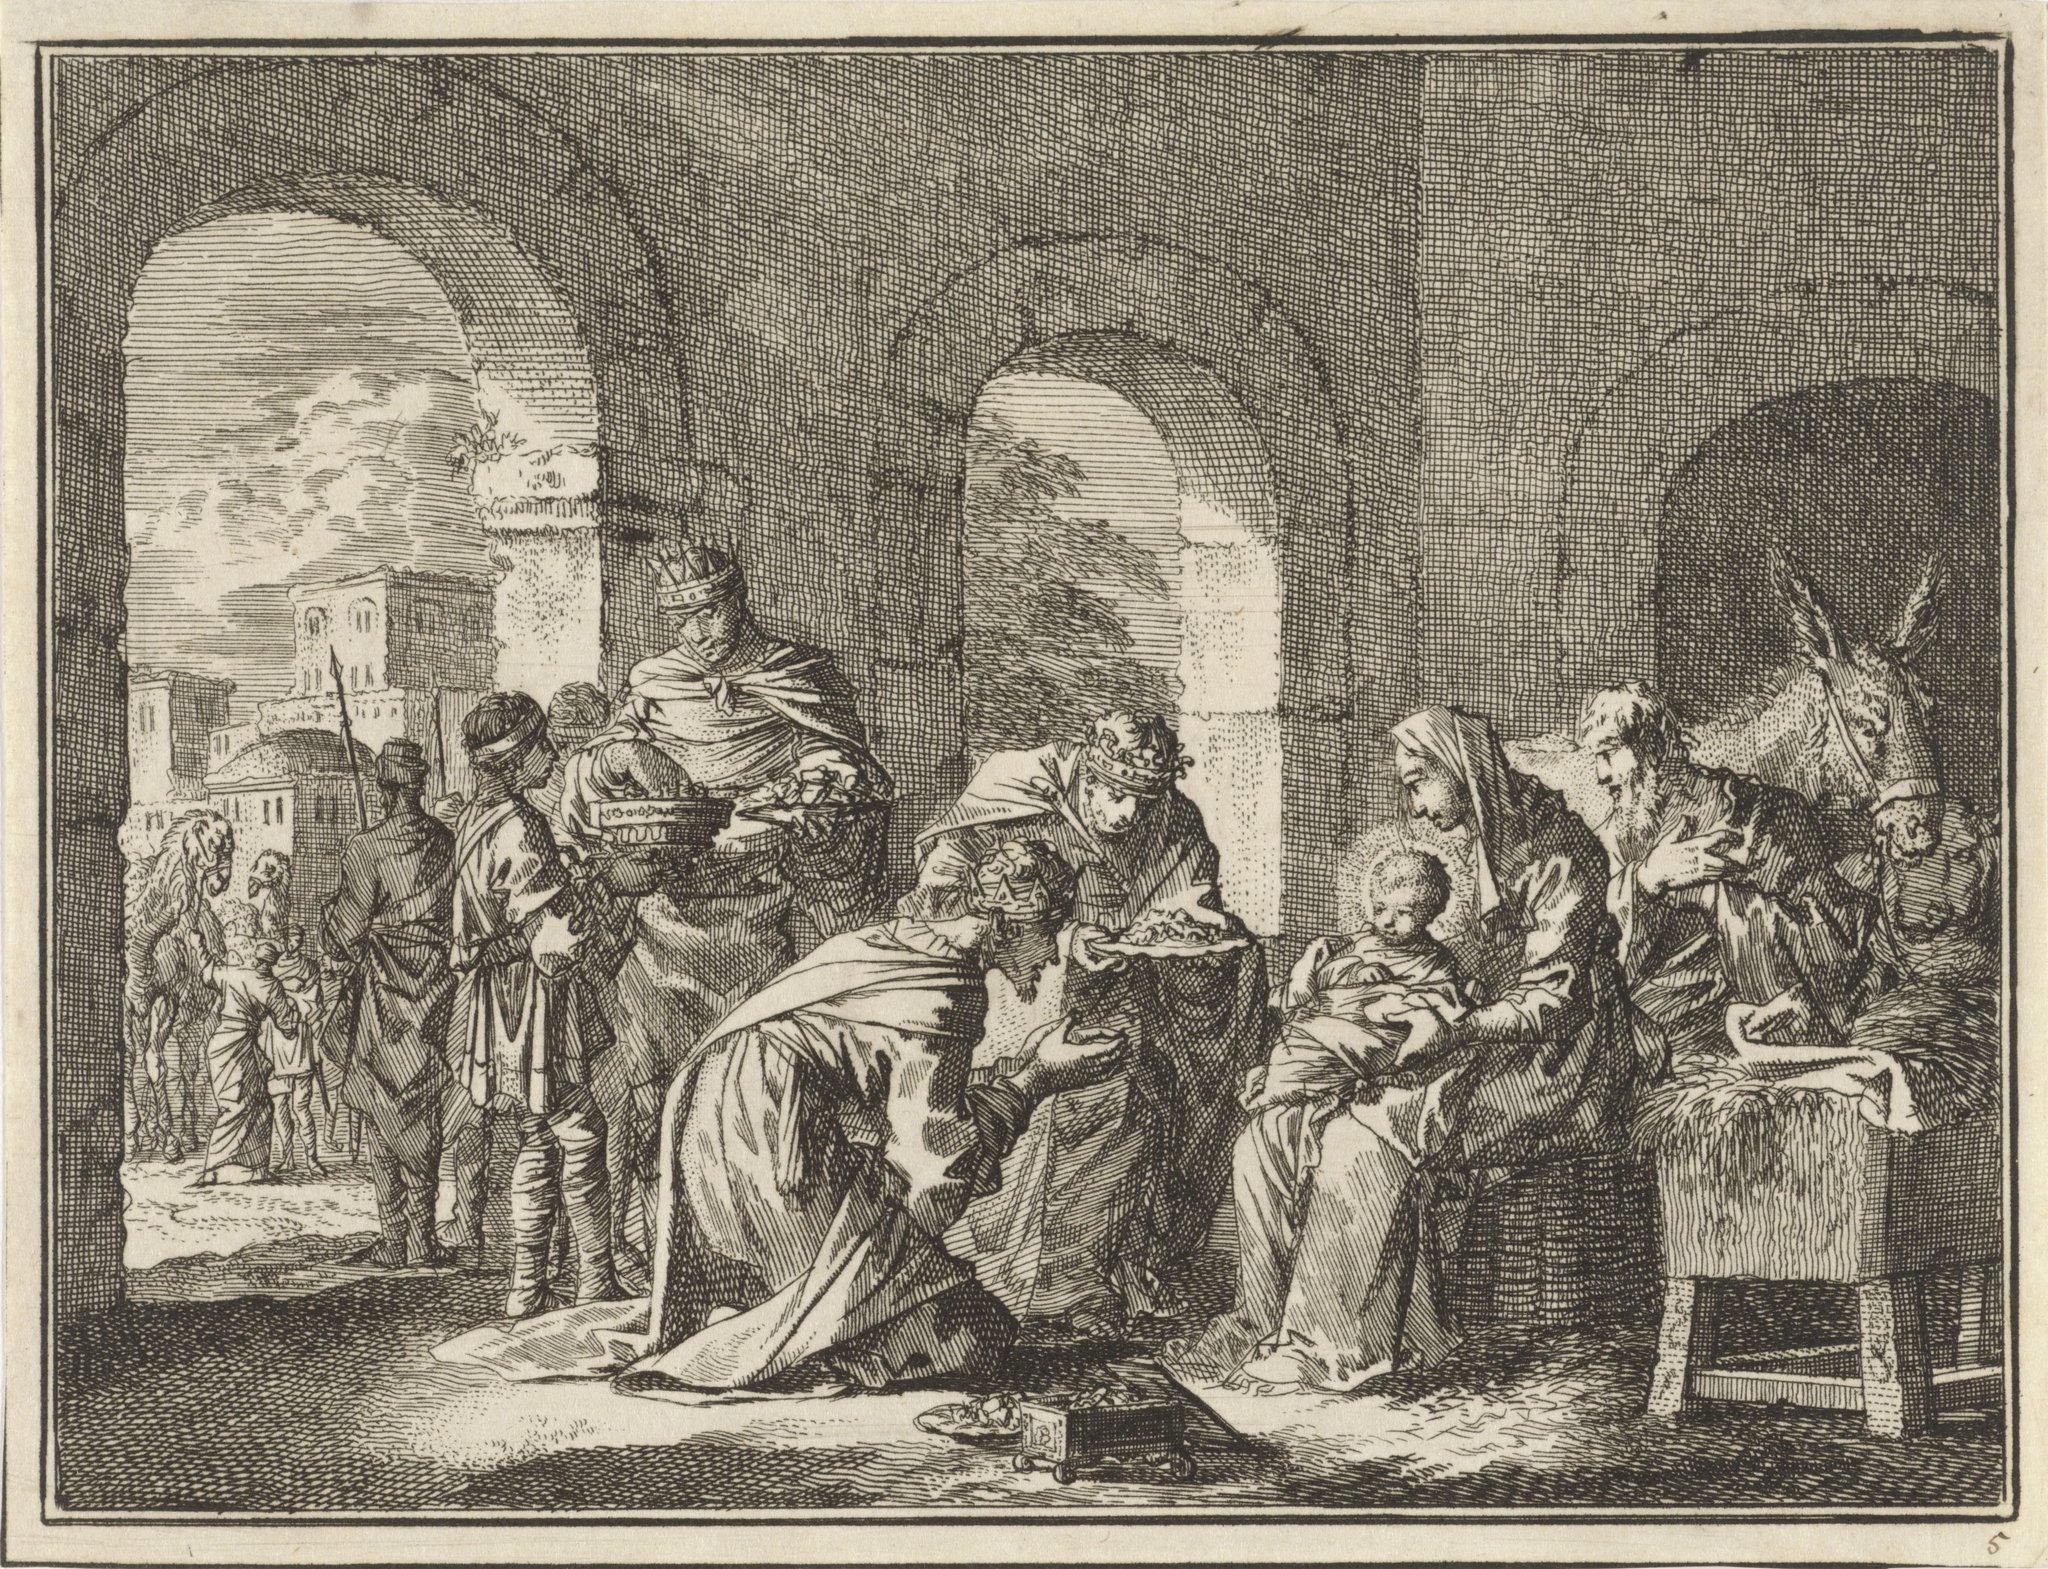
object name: print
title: Aanbidding door de koningen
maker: jan luyken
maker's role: draughtsman, print maker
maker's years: 1649-1712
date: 1712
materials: paper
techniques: etching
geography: amsterdam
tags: adoration of the kings: the wise men present their gifts to the christ-child (gold, frankincense and myrrh)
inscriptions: collector's mark: Lugt 2228, number: ‘5’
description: Proefdruk van illustratie uit: Luyken, Jan. De schriftuurlyke geschiedenissen en gelykenissen van het Oude en Nieuwe Verbond, 2 delen. Amsterdam: Wed. Pieter Arentsz II en Cornelis van der Sys, 1712, dl. II.